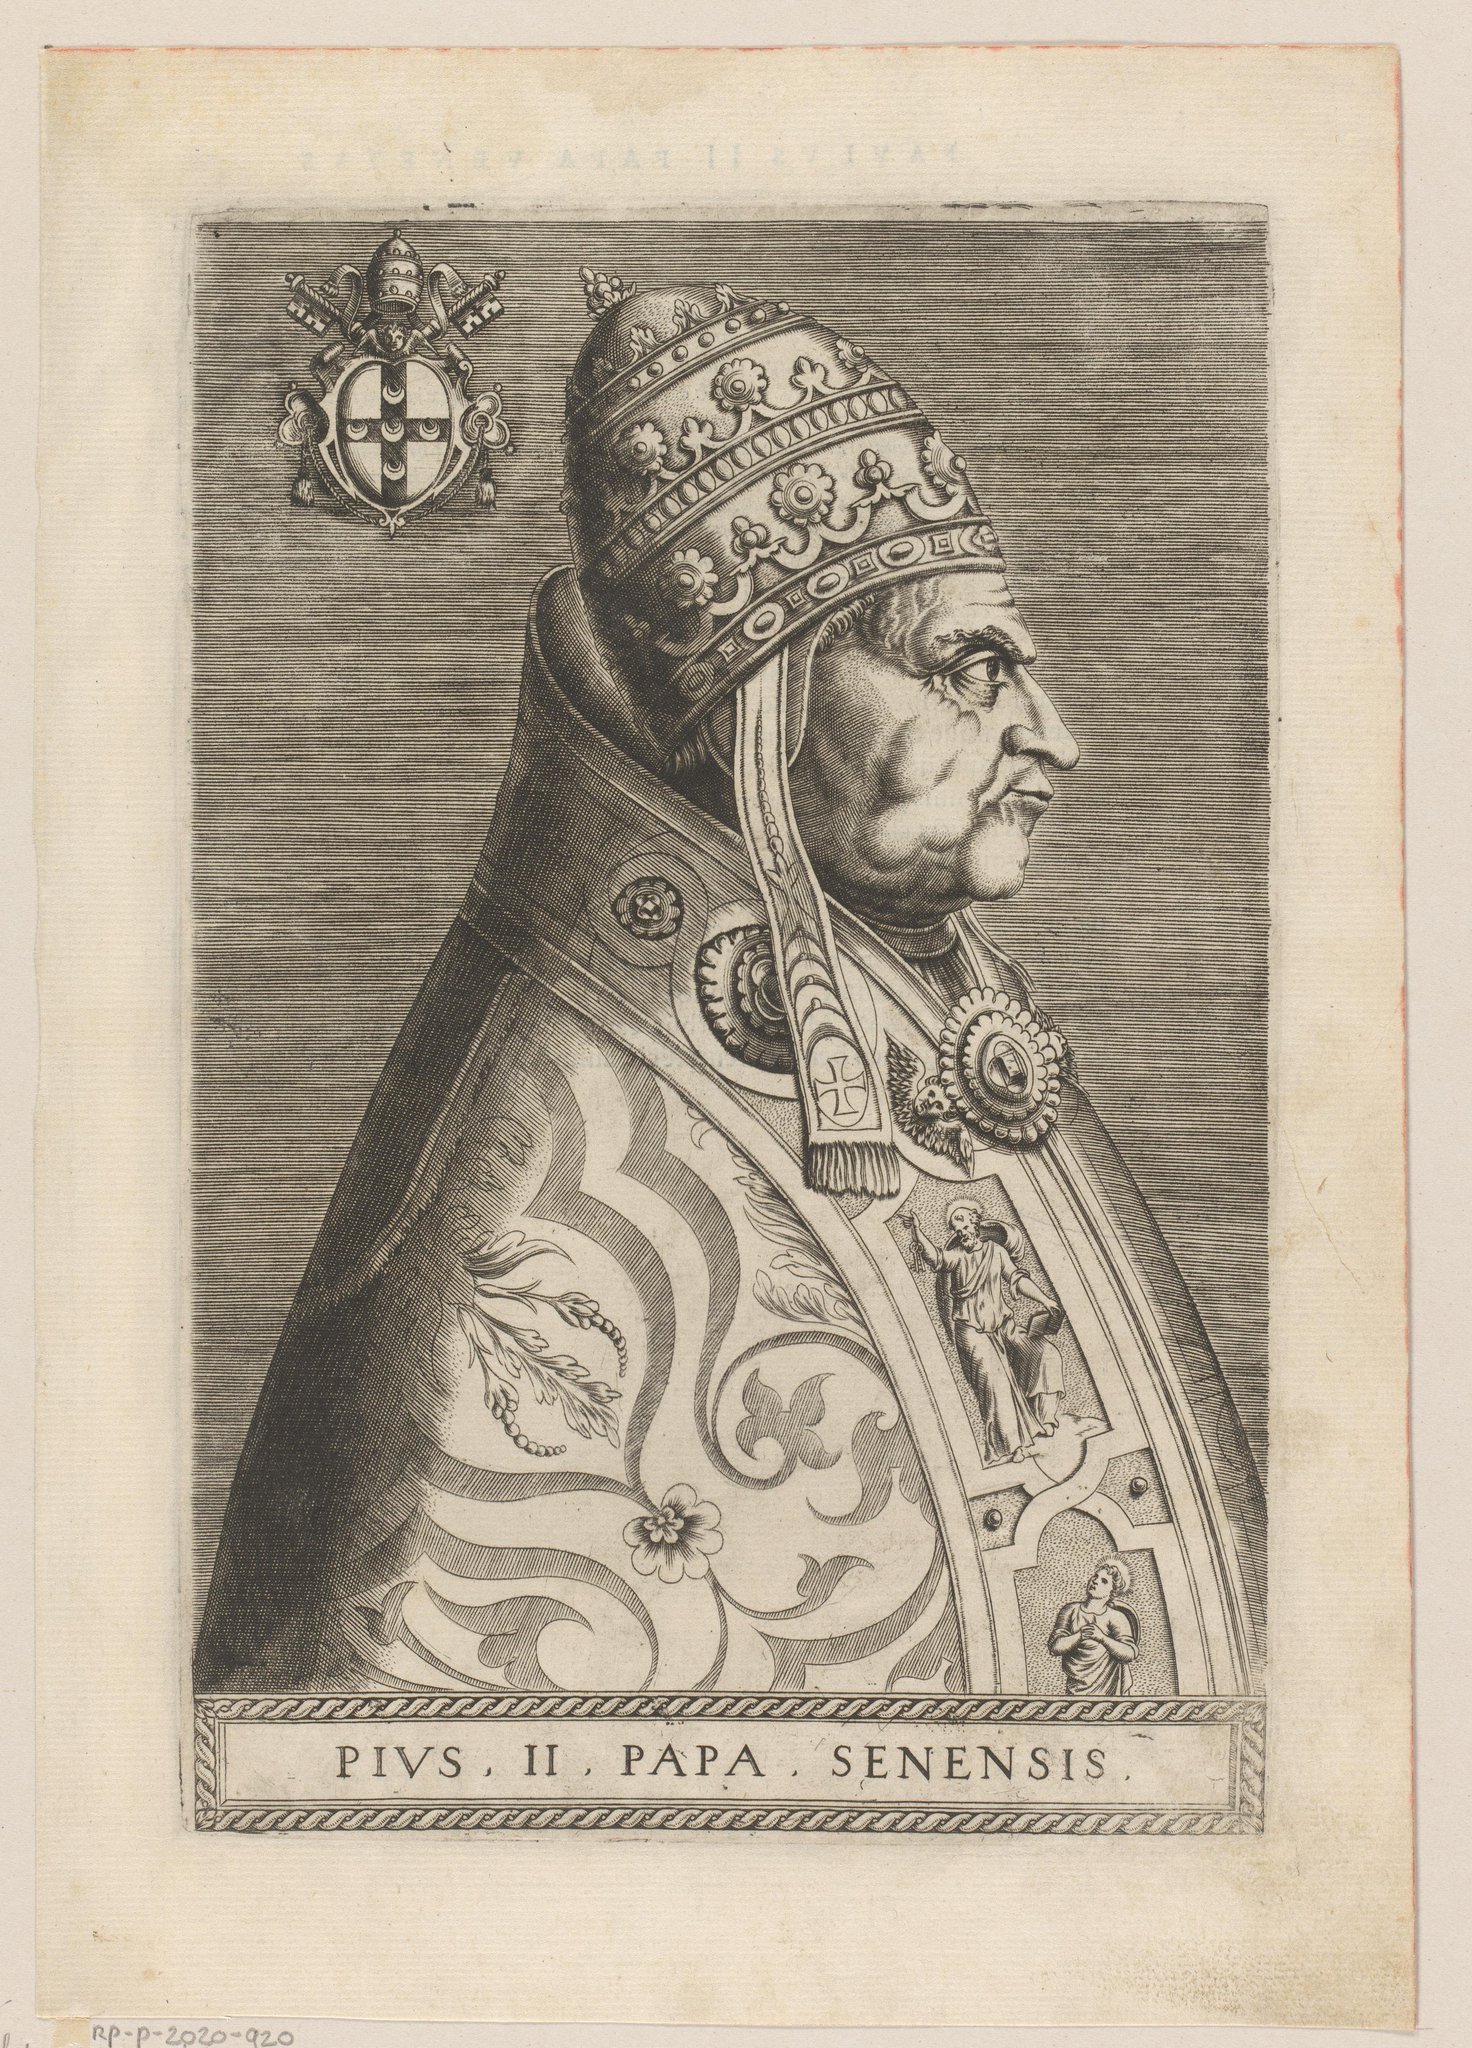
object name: book illustration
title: Pius II papa senensis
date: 1568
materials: paper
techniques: engraving, letterpress printing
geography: rome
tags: rome, historical persons, pope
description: Prent uit: Panvinio, Onofrio. 27 pontificum maximorum elogia et imagines accuratissime ad uiuum aeneis typeis delineatae. Rome: Antonio Lafreri, 1568.